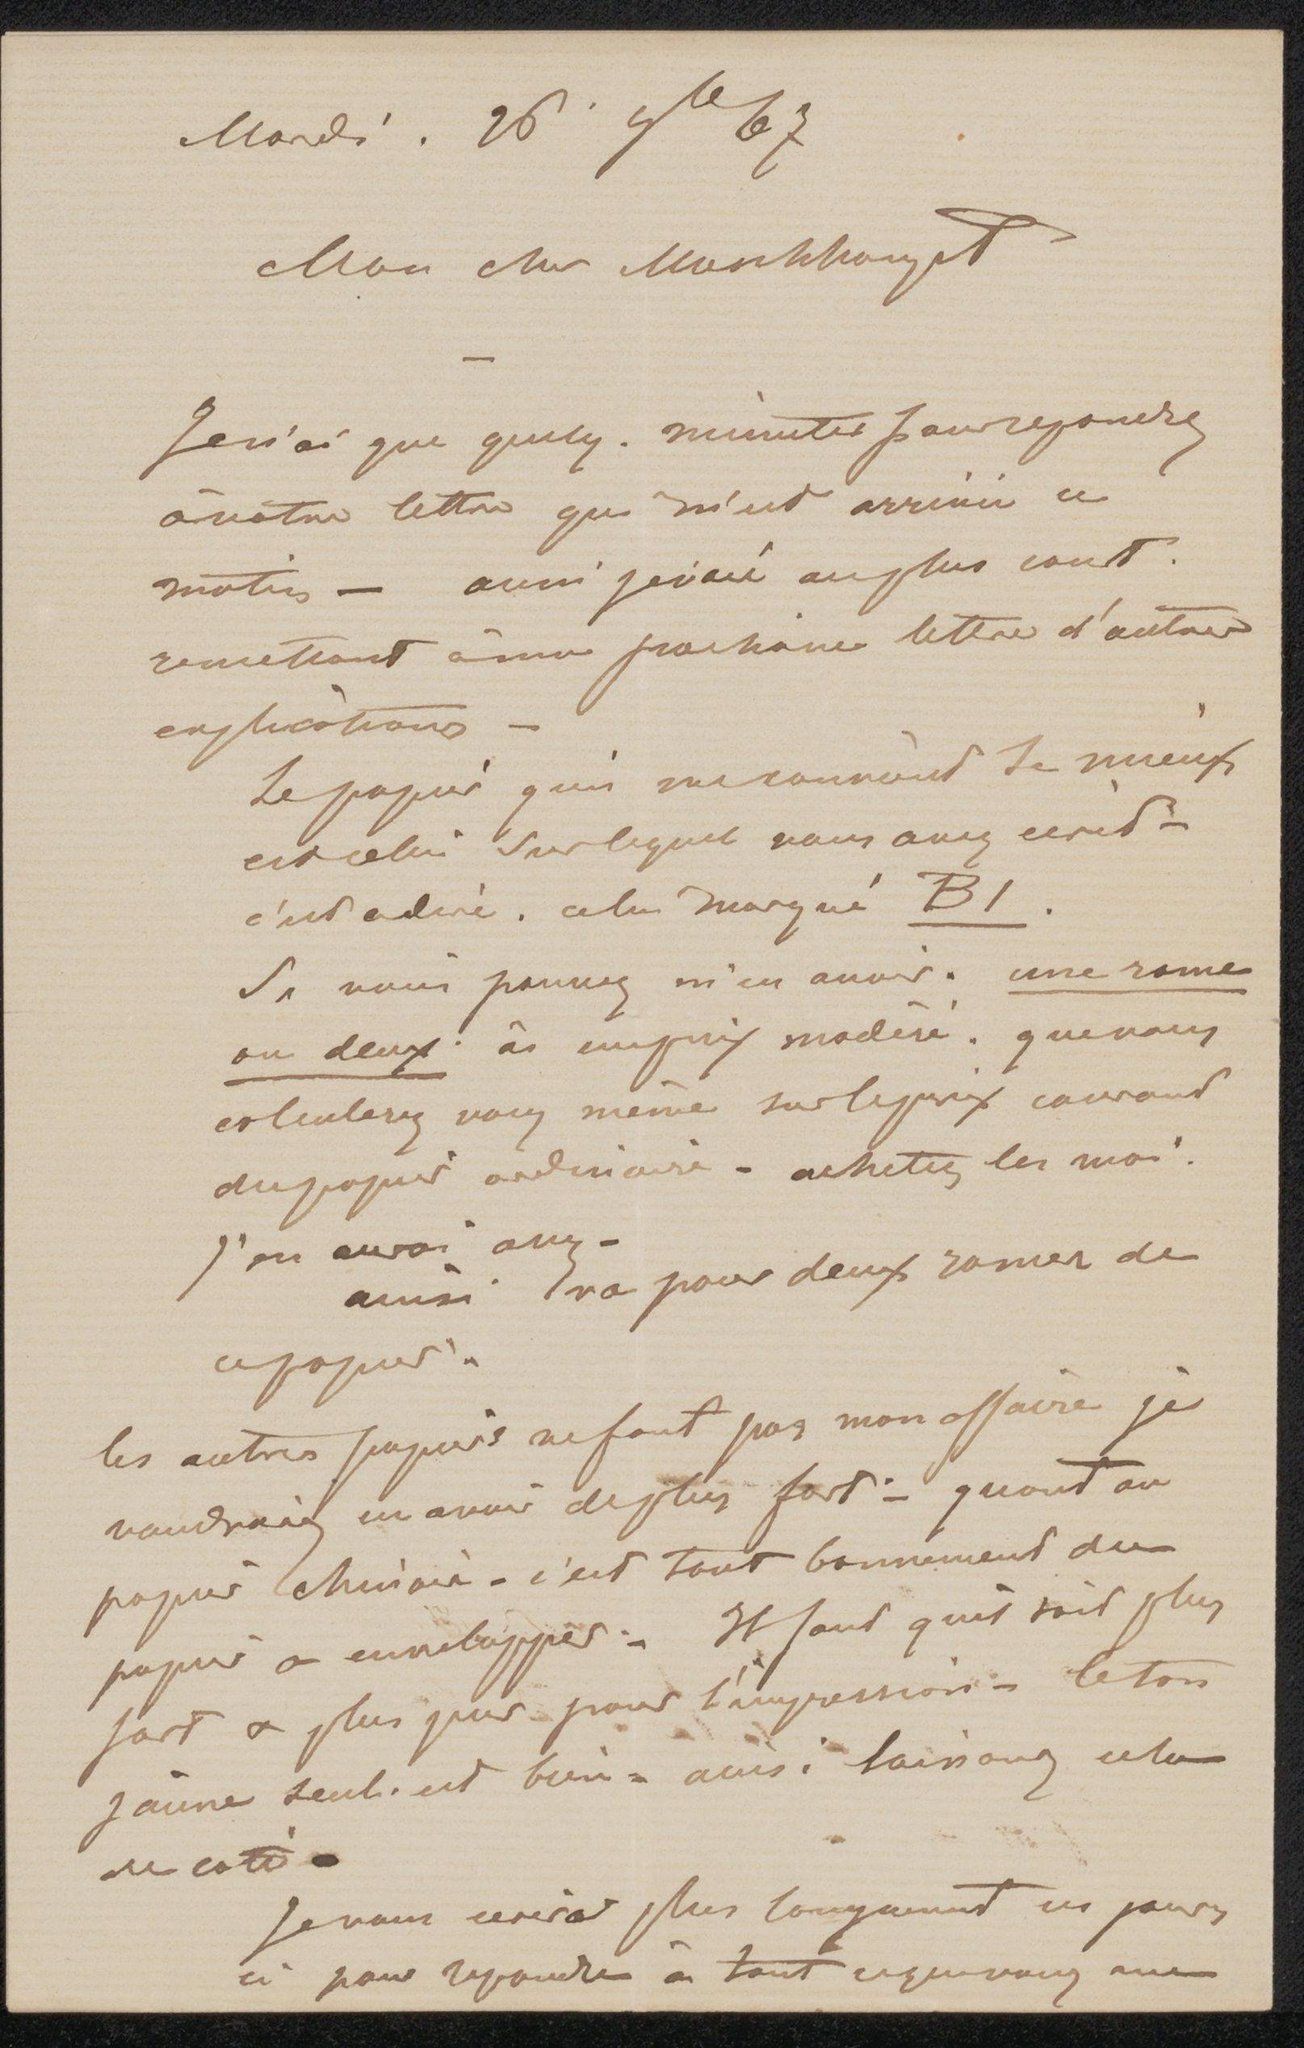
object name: letter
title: Brief aan Jan Hendrik Maschaupt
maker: adolphe mouilleron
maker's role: draughtsman, print maker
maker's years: 1820-1881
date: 1867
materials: ink, paper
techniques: pen, writing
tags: amsterdam, painter, jan hendrik maschaupt, the graphic arts, exhibition ~ art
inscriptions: collector's mark: ‘RPK’